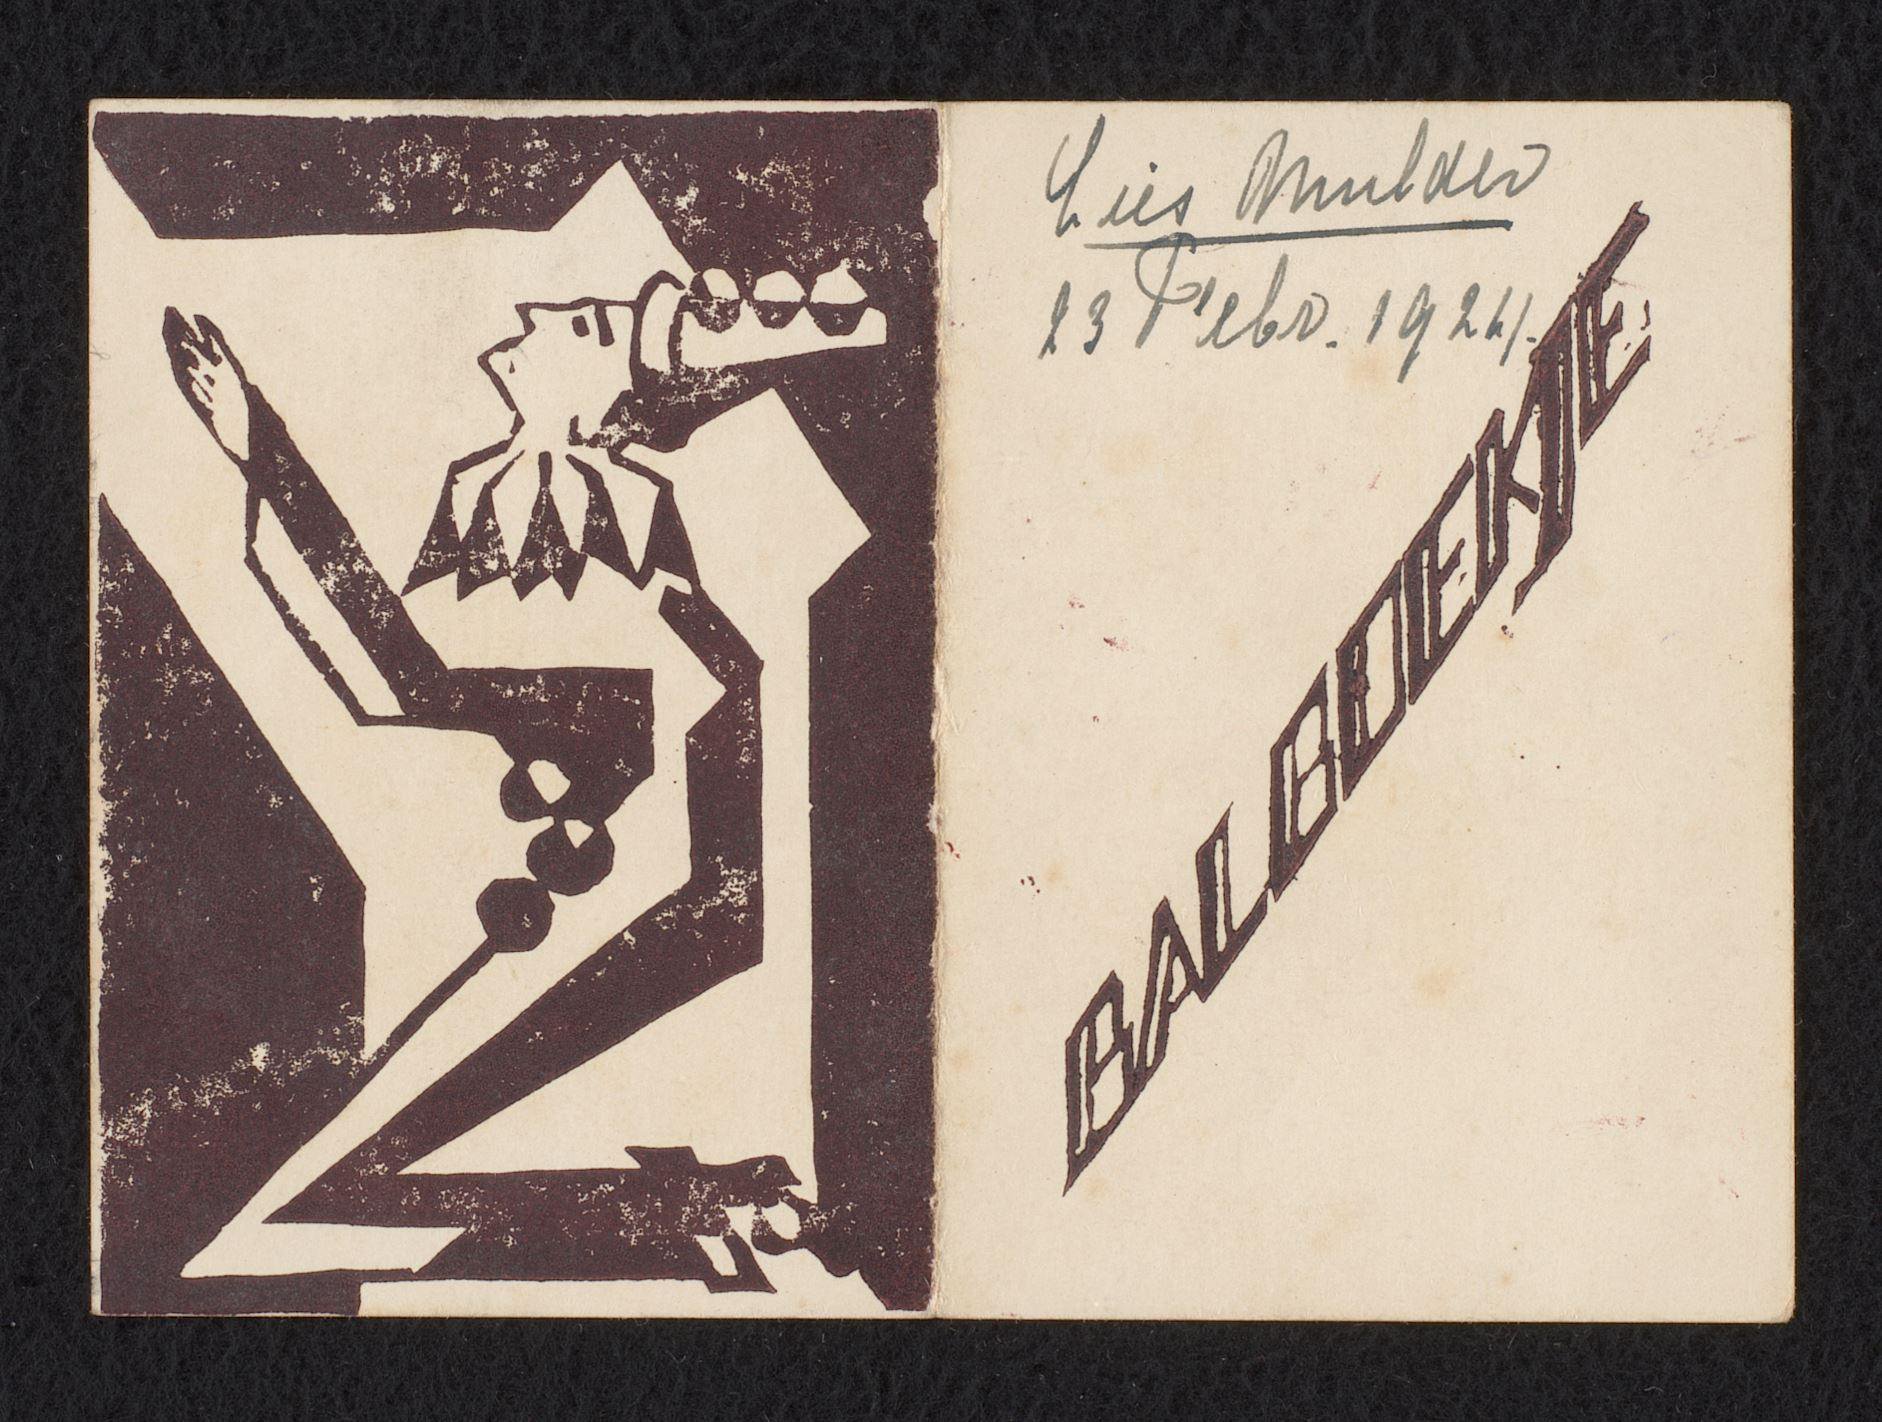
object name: dance card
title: Balboekje voor een bal op 23 februari 1924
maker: Anonymous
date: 1924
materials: paper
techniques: woodcut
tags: ball, formal dance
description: Op de voorzijde: 'Balboekje', met de hand is daarbij de naam 'Lies Mulder' en de datum '23 Febr. 1924' geschreven. Binnenin de lijst van 13 dansen met daarachter de namen van de personen waarmee Lies Mulder danste. Op de achterzijde een knielende clown.